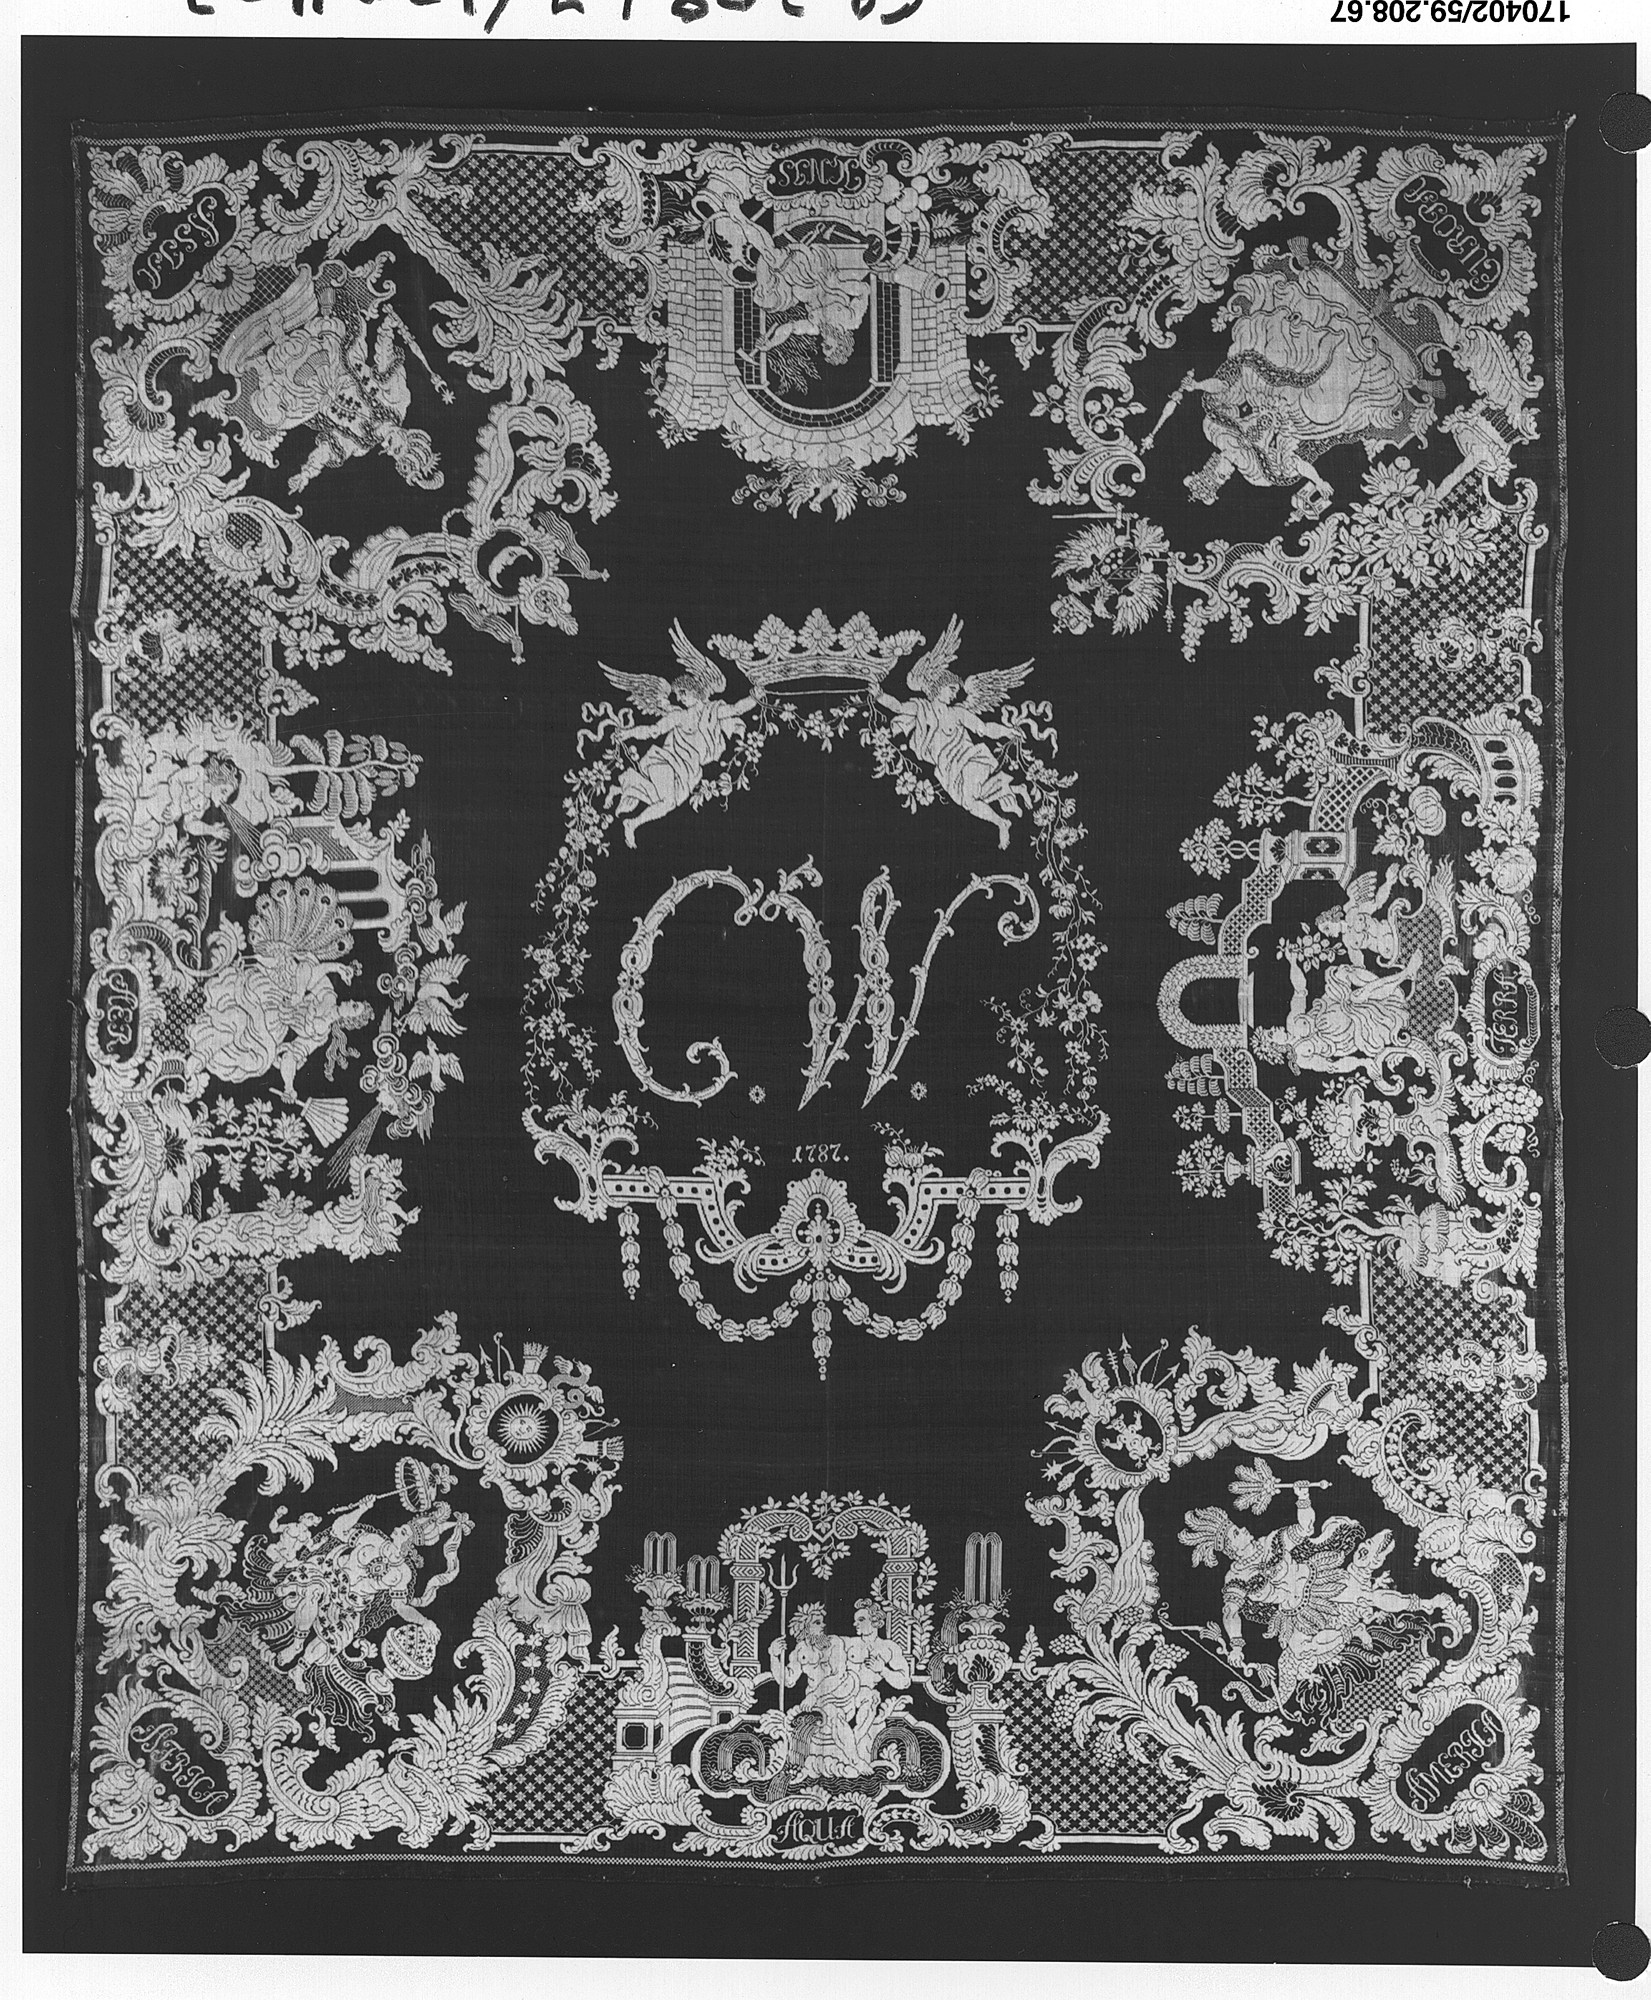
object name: napkin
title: Banquet napkin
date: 1787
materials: linen, silk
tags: men